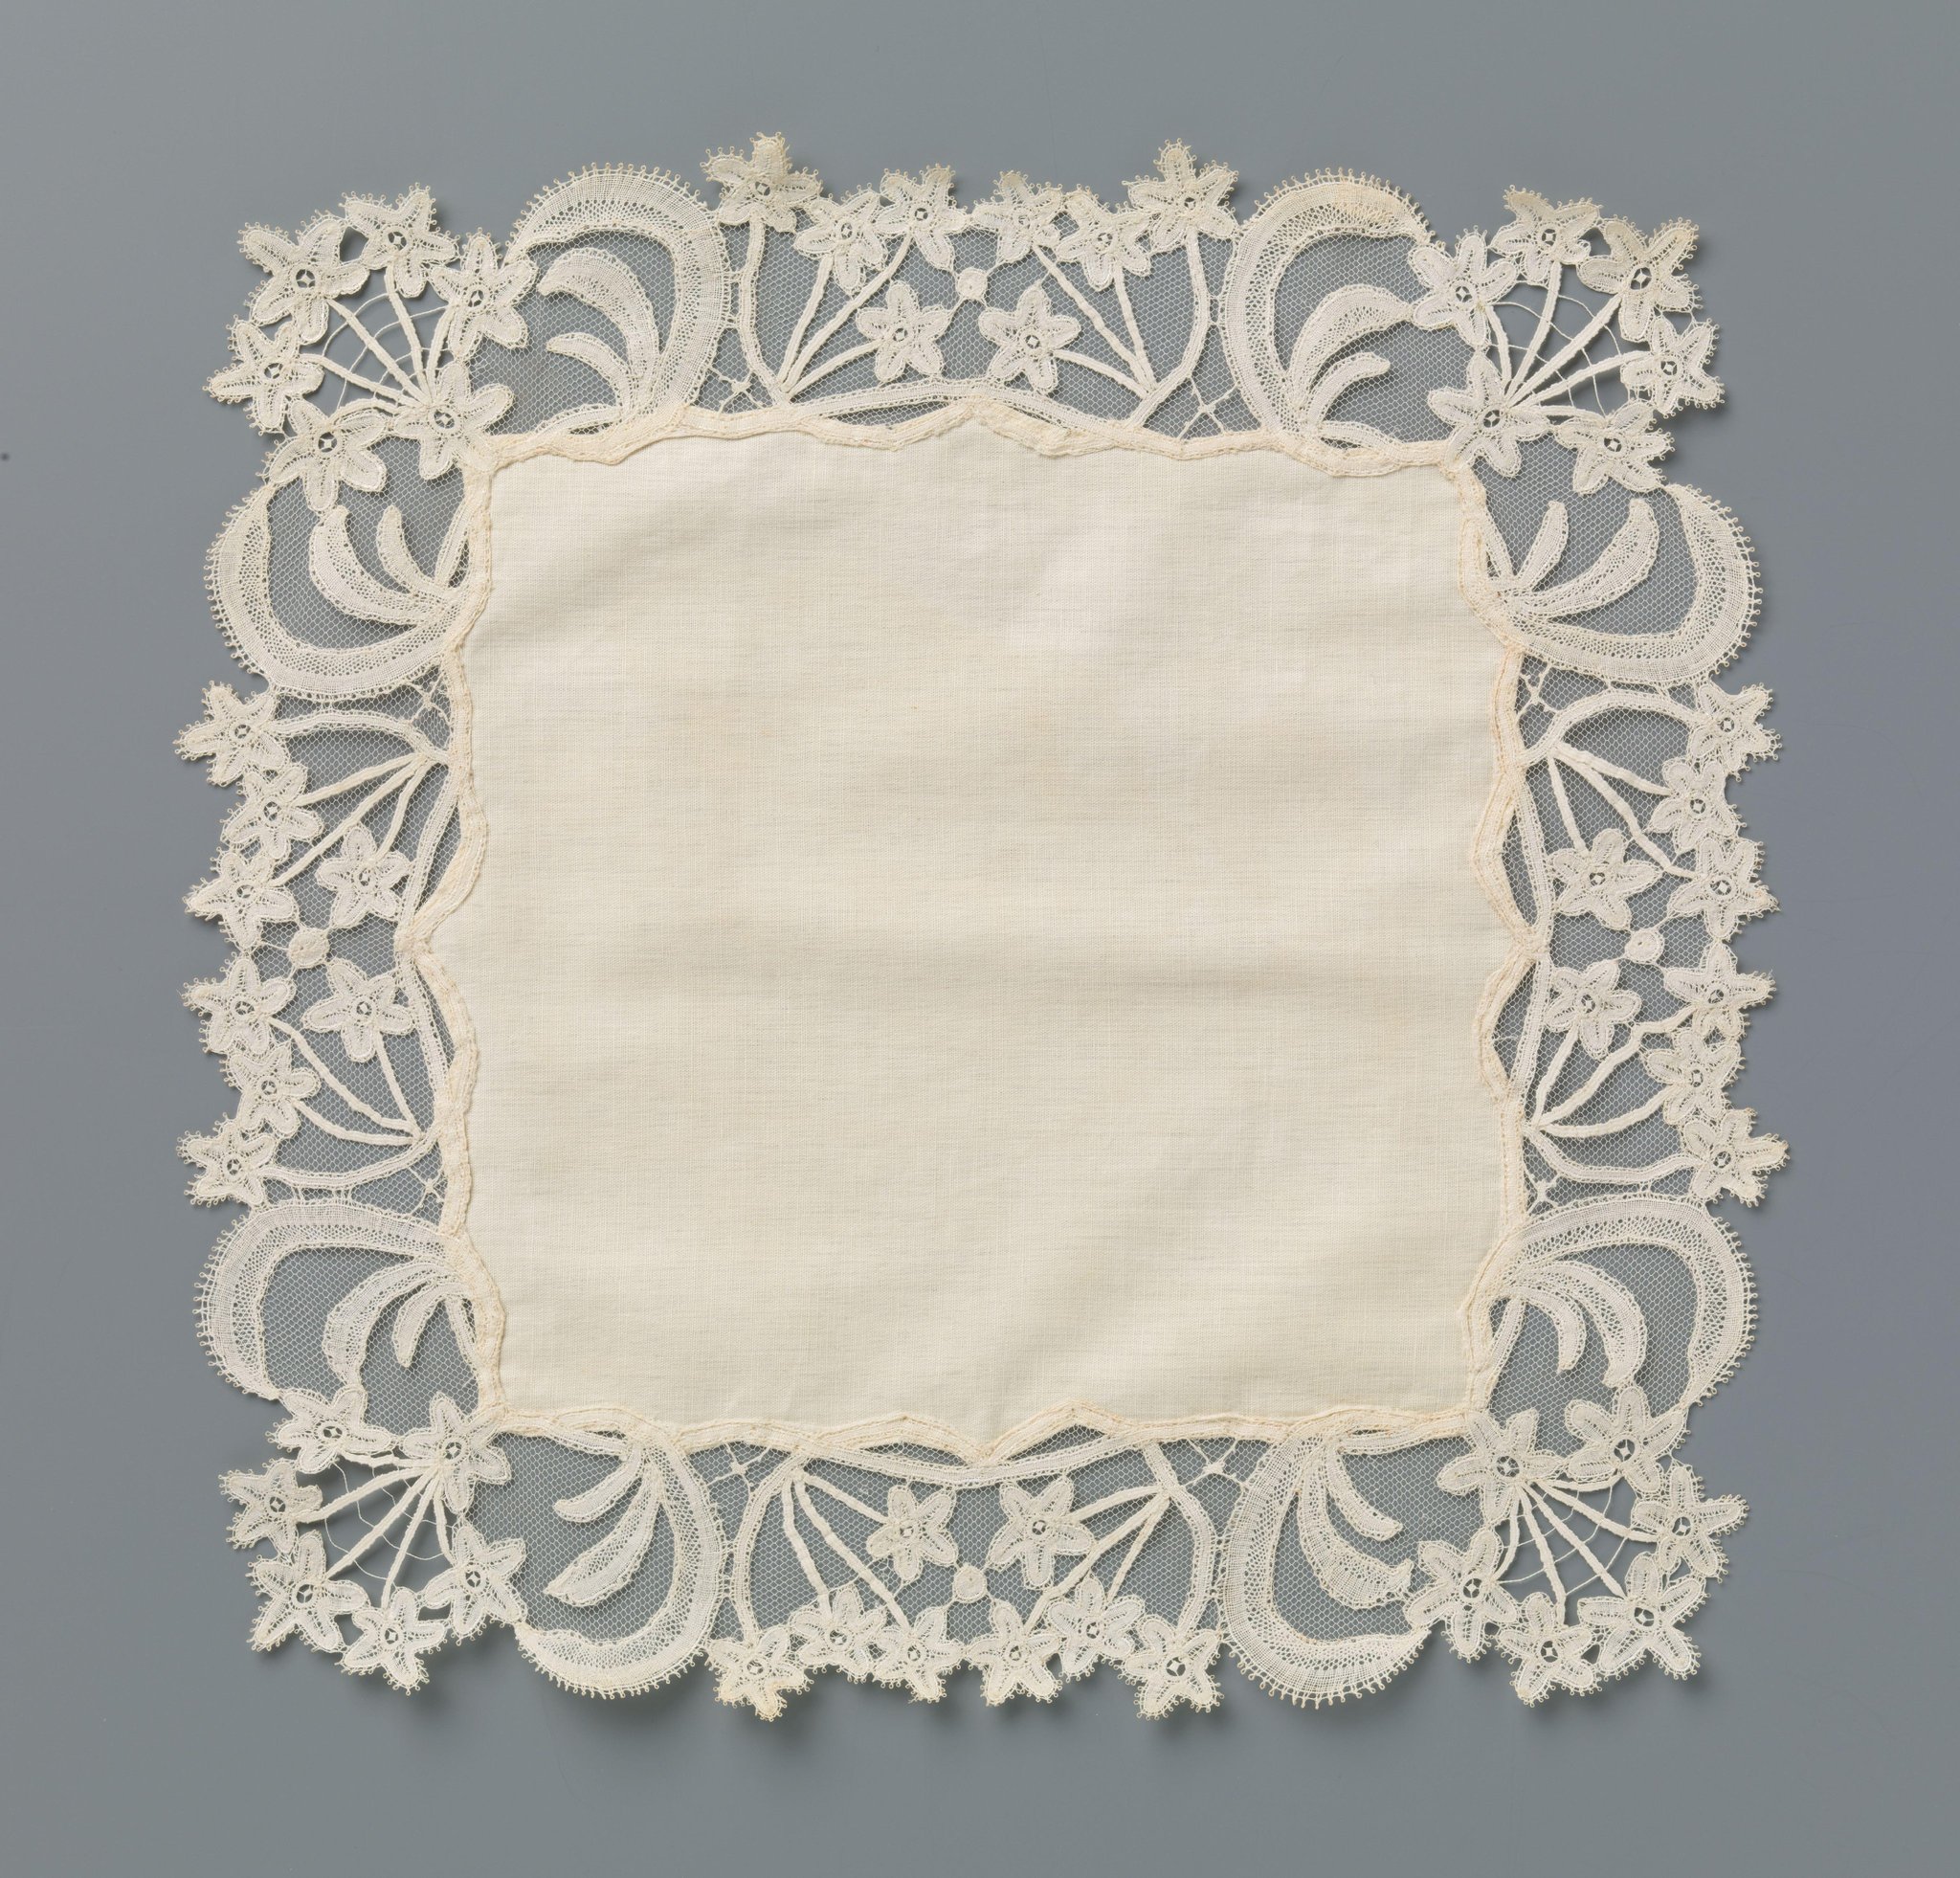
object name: handkerchief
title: Zakdoek met rand van applicatiekant met sikkelbladeren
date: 1903-1904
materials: linen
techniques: lace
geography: apeldoorn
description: Zakdoek met rand van naturelkleurige applicatiekant, kloskant - duchesse-kant - genaaid geappliceerd op machinale tule. Patroon met sikkelbladeren.